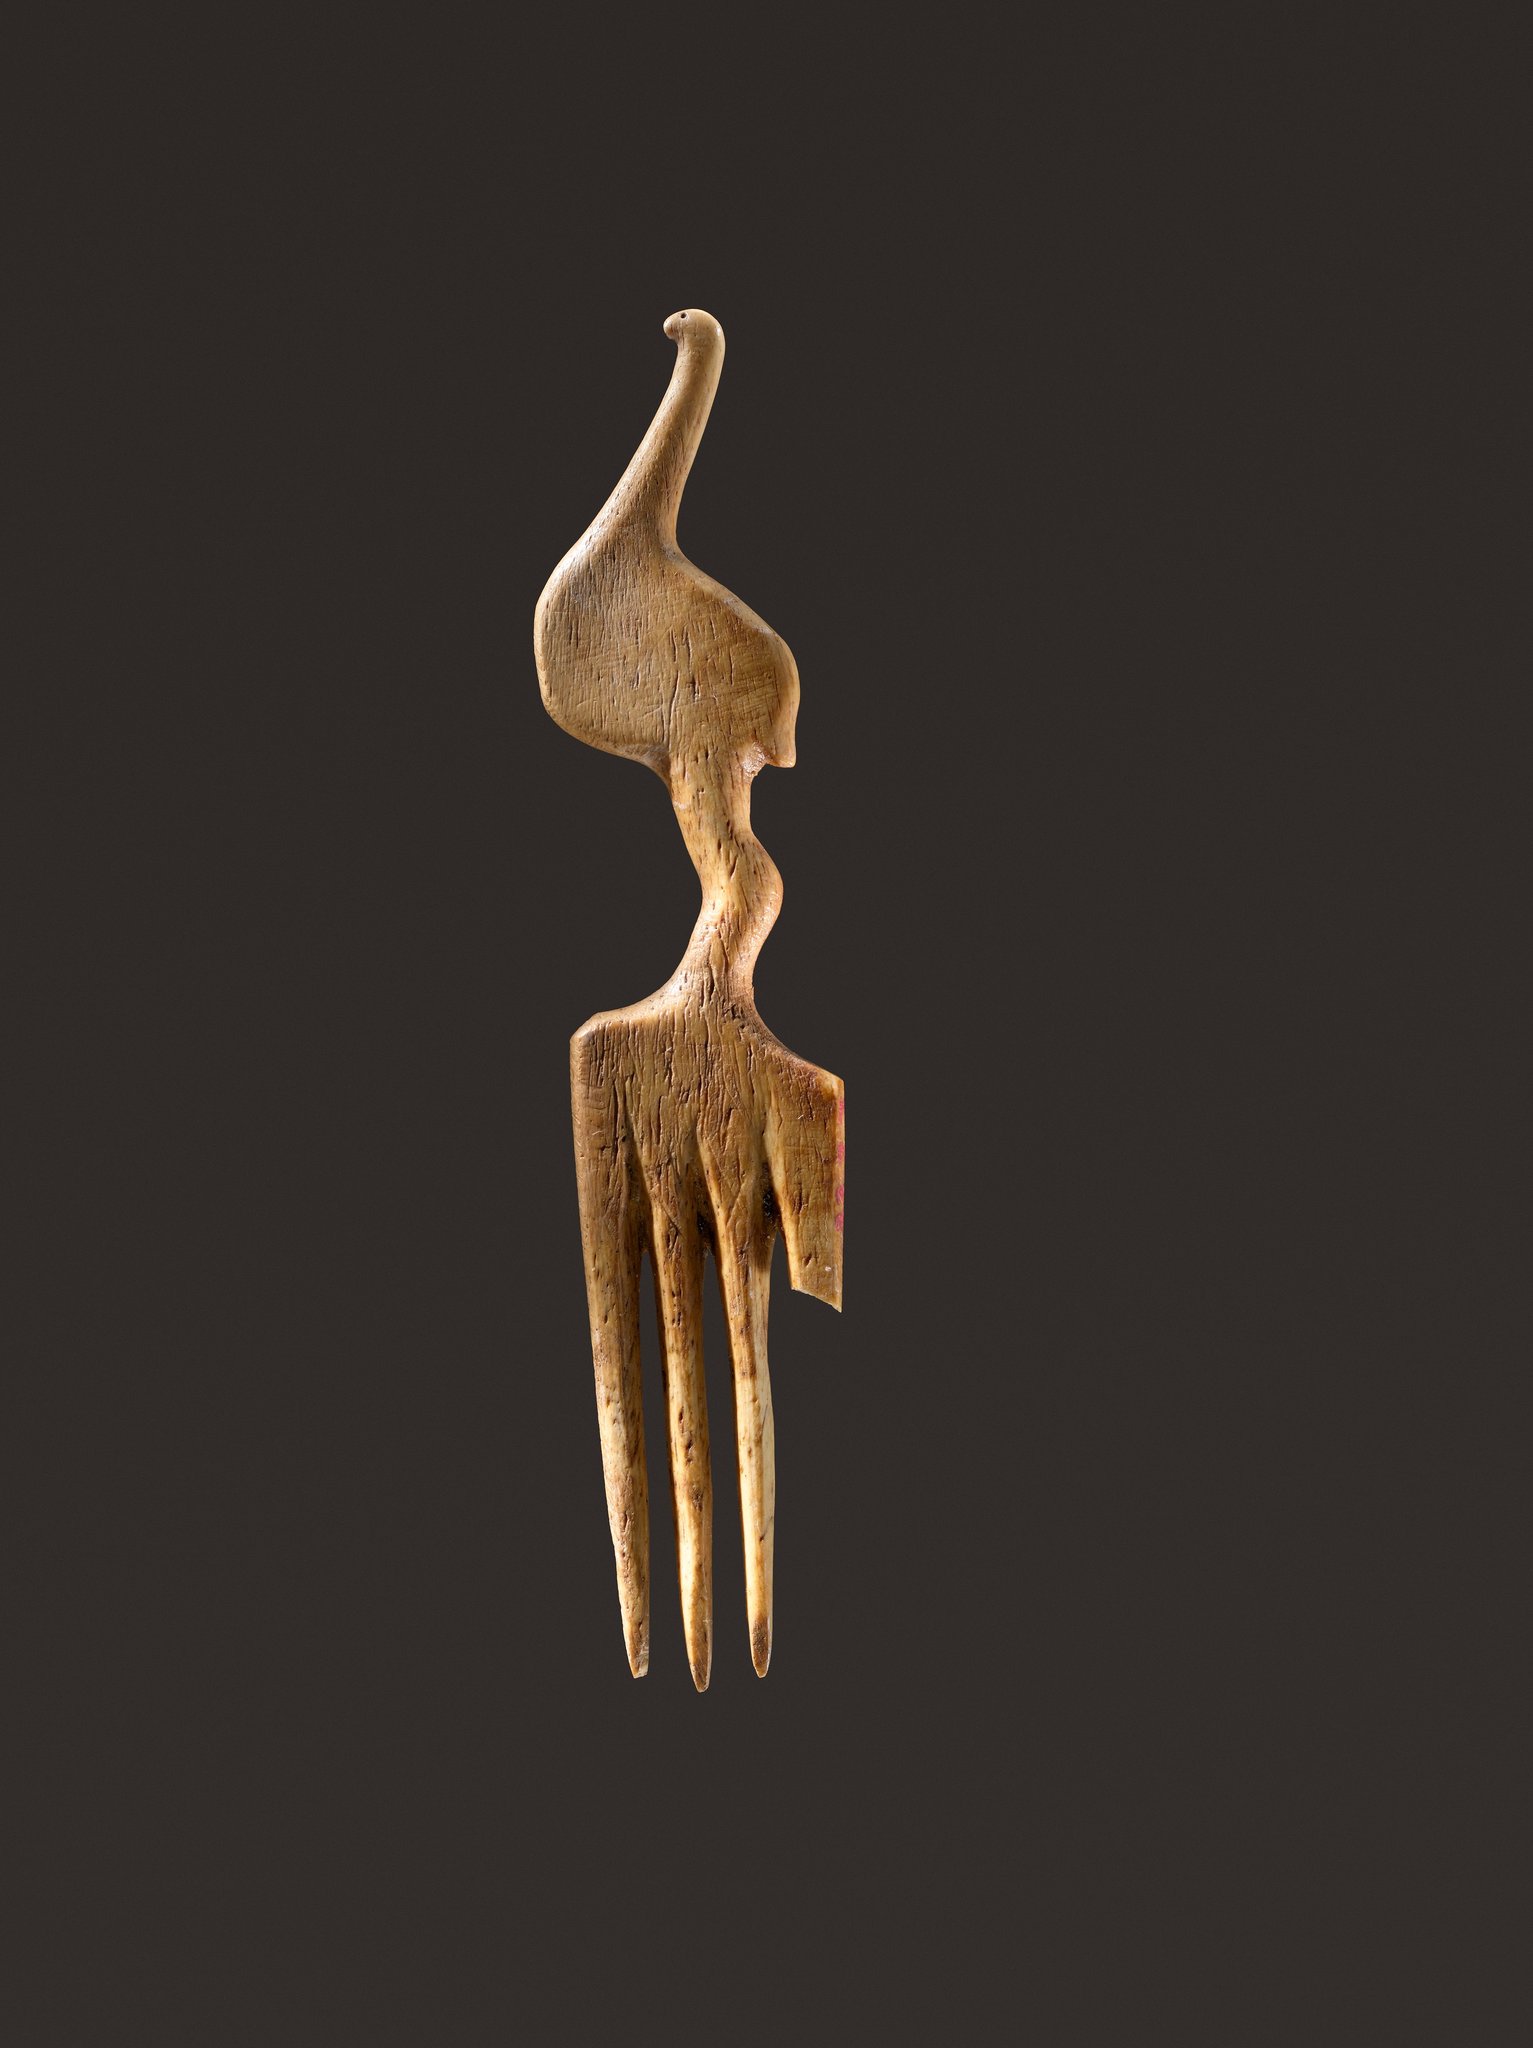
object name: comb, ostrich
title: Comb decorated with an ostrich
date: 3900-3500 BCE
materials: bone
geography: egypt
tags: birds